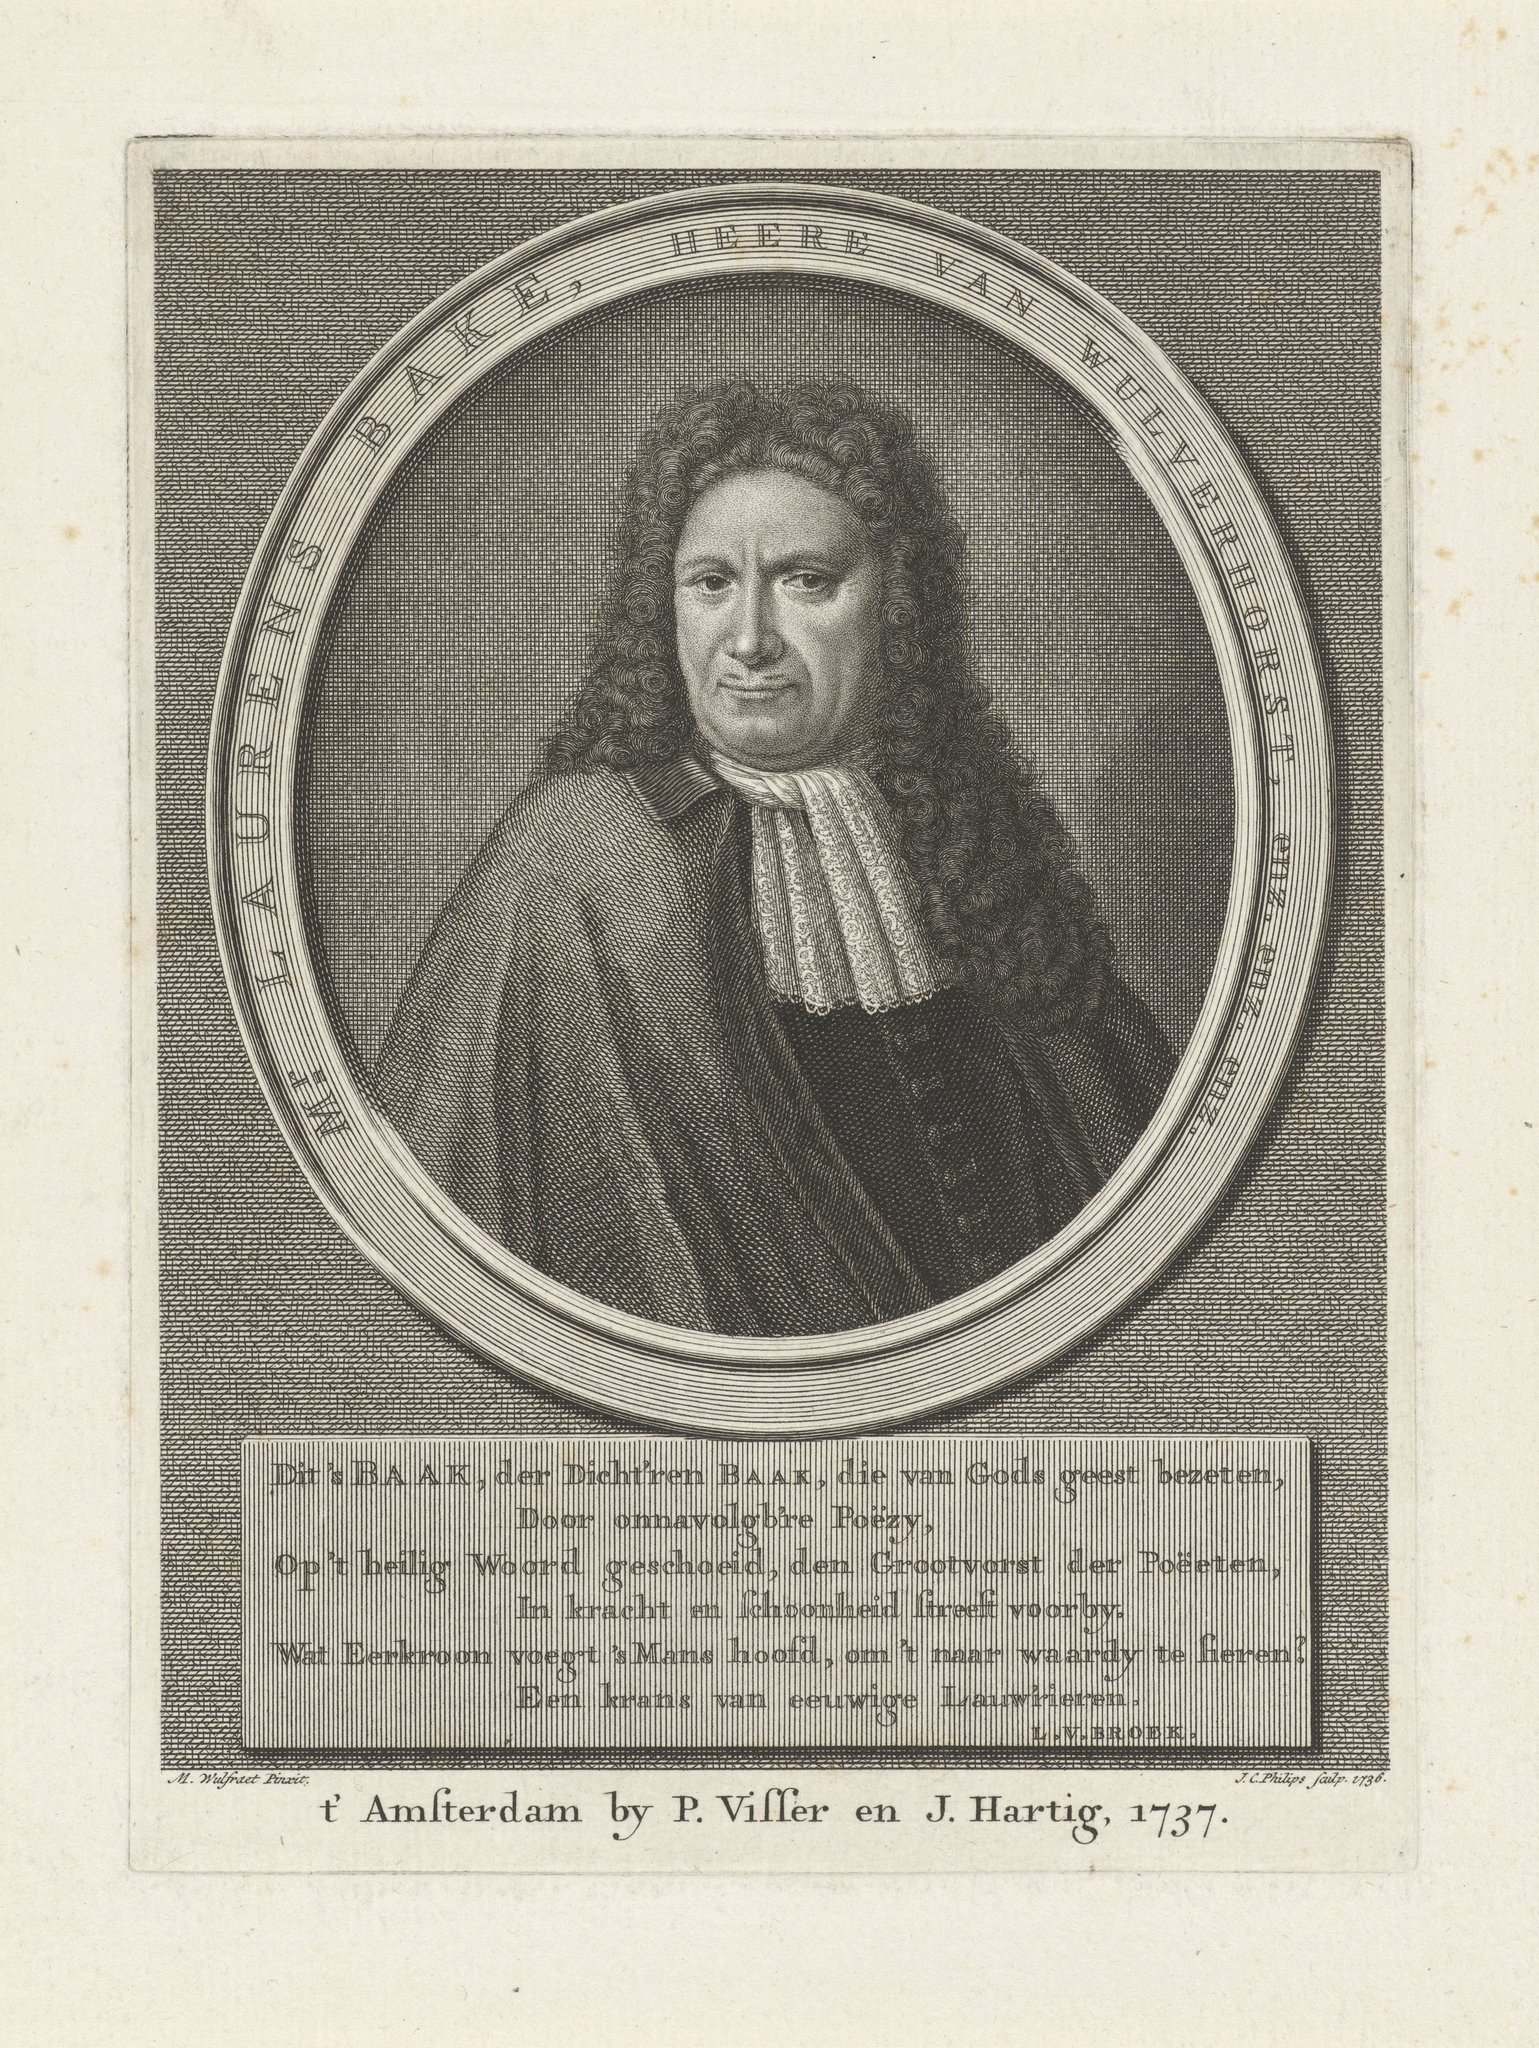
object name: print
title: Portret van de dichter Laurens Bake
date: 1737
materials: paper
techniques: engraving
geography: amsterdam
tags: laurens bake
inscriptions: collector's mark: Lugt 2228